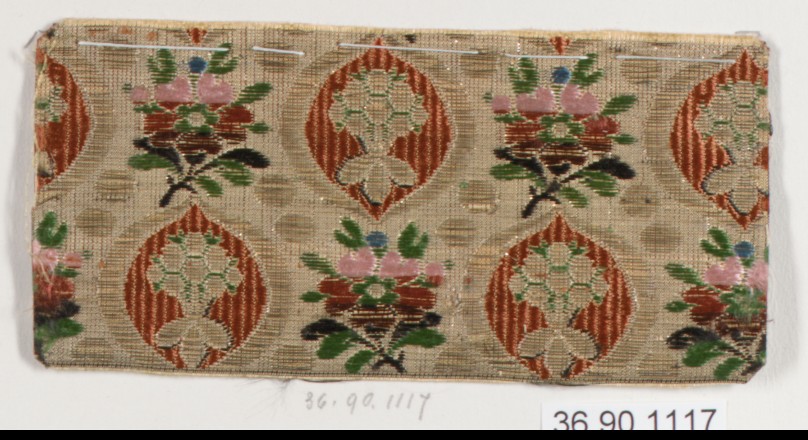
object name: sample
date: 1701-1900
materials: metal thread, silk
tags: flowers